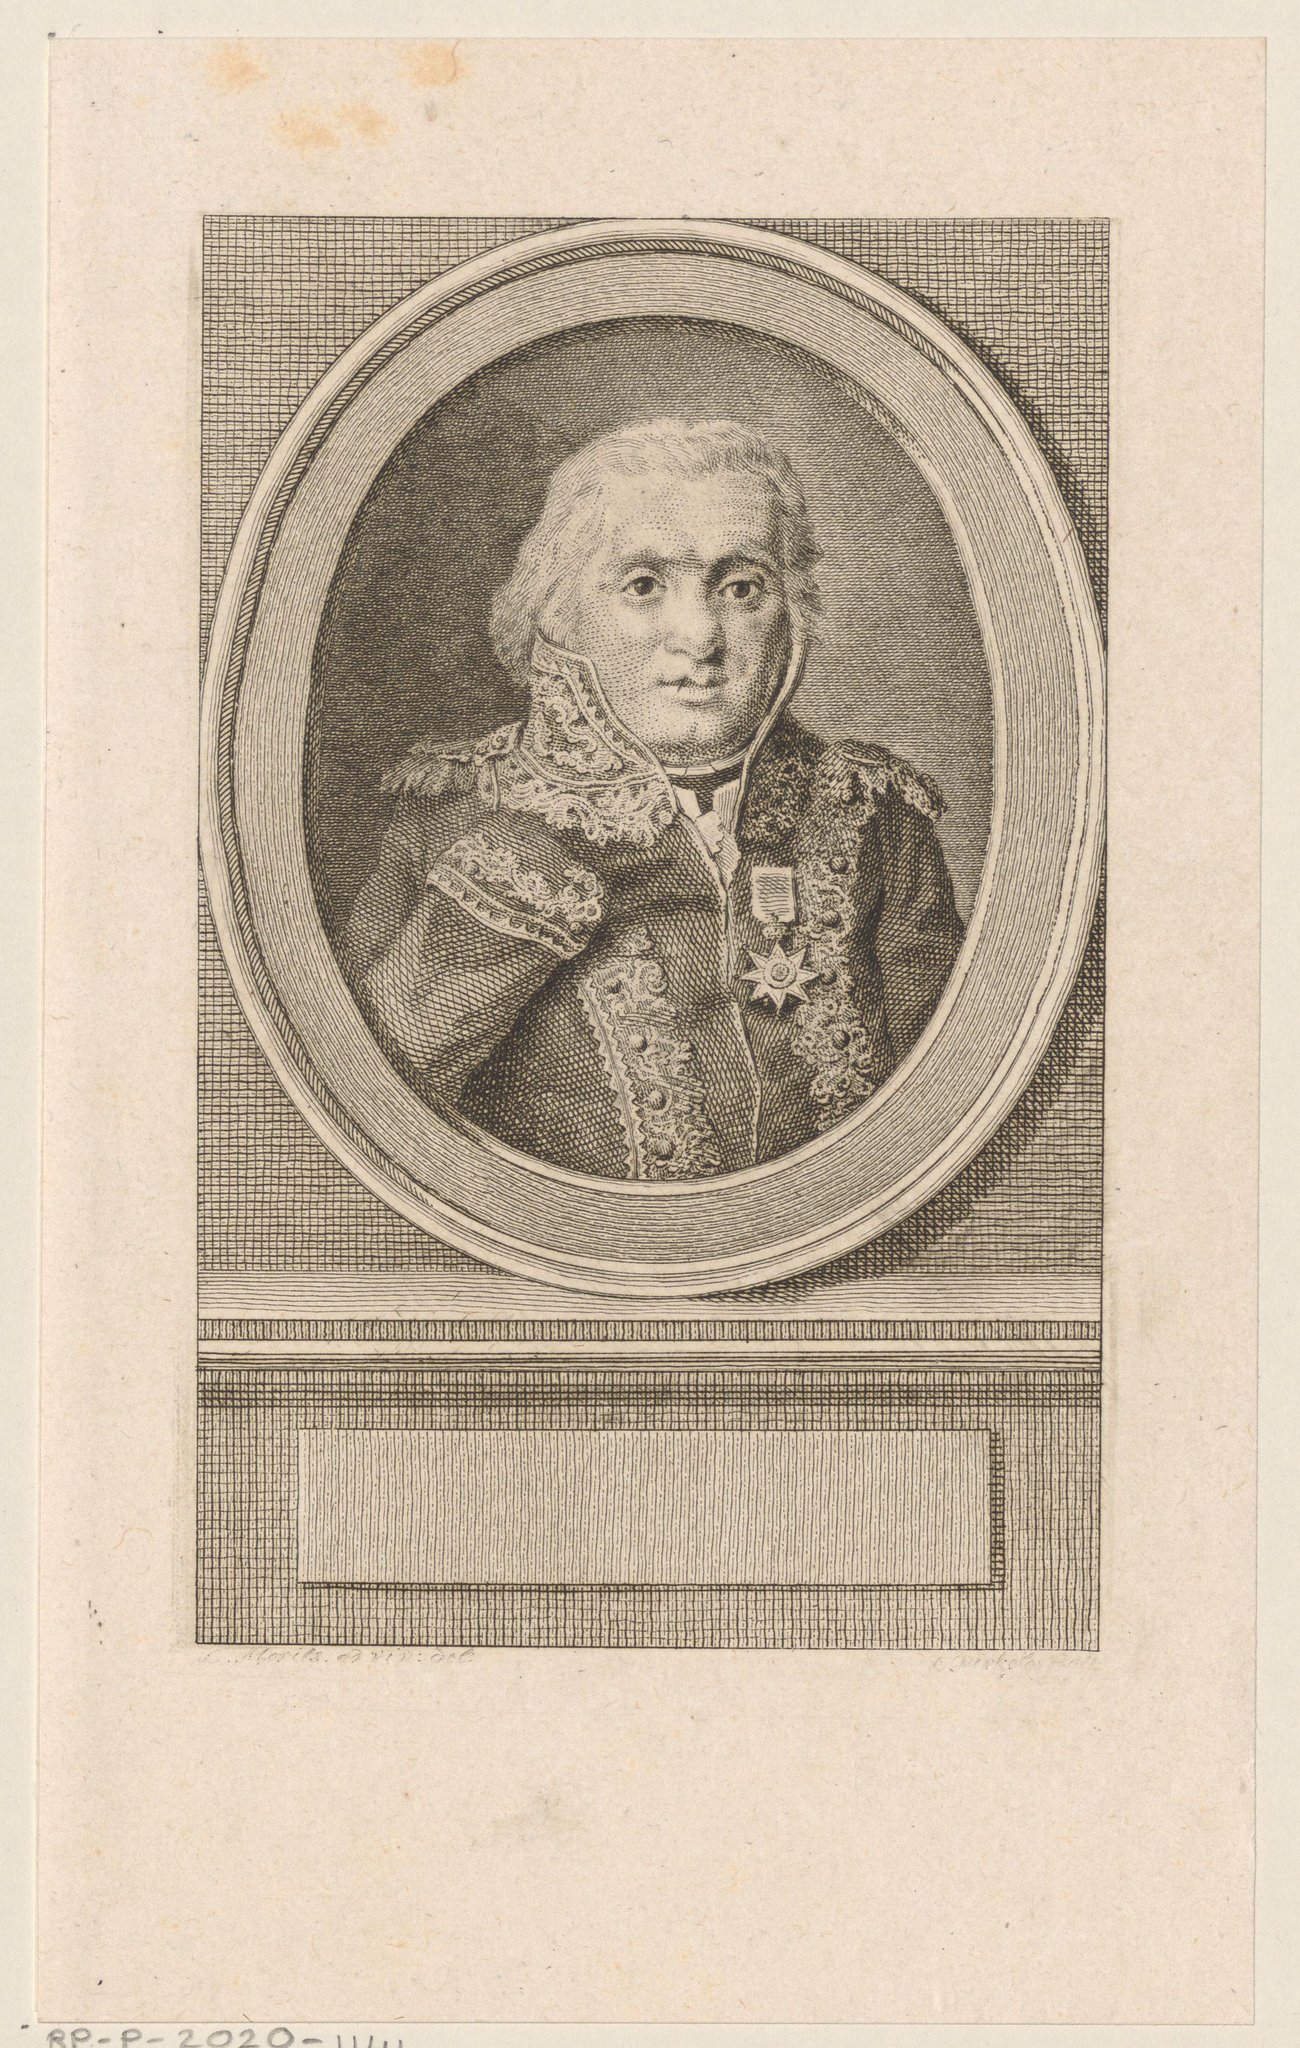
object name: print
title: Portret van Johan Arnold Bloys van Treslong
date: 1786-1811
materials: paper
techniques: engraving, etching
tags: amsterdam, historical persons, officer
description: Latere staat van de prent verschenen in: Loosjes, Petrus. Vaderlandsche historie, (...) ten vervolge van Wagenaars Vaderlandsche historie. Amsterdam: Johannes Allart, 1786-1811, dl. 43.